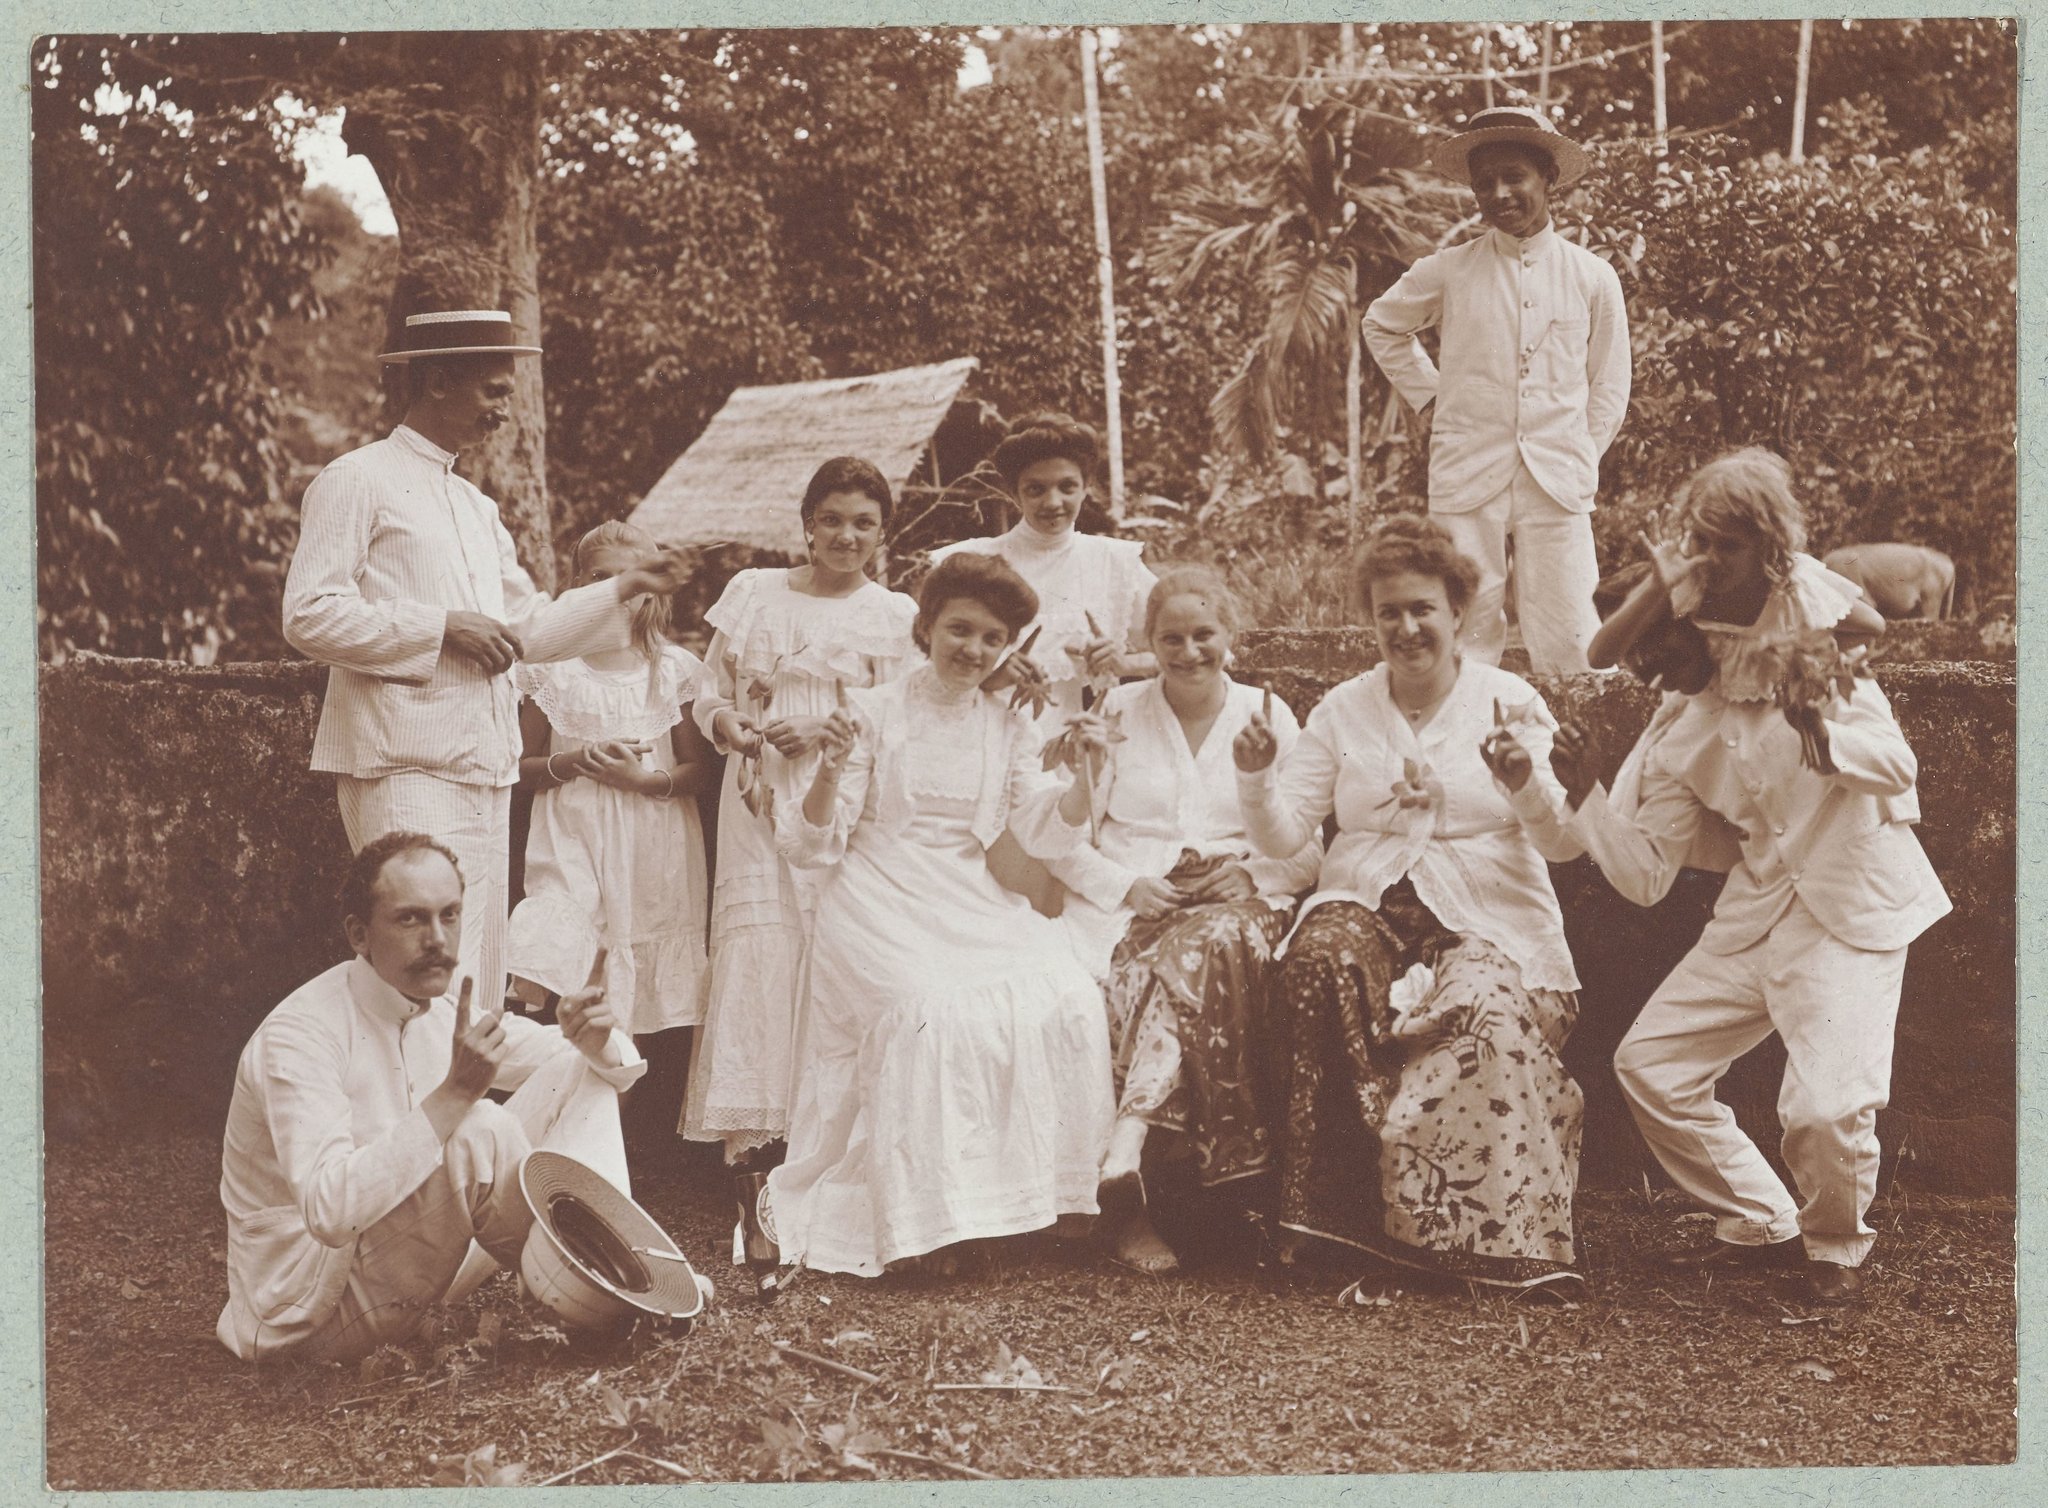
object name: photograph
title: Groepsportret van jolige mensen in Batuan, gekleed in het wit.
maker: frits freerks fontein fz.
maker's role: fotograaf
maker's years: 1882-1928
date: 1910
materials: cardboard, paper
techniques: gelatin silver print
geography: madura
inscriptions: caption: ‘Batoewan bij Soemenep 1910’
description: De mannen dragen witte tropenuniformen waarvan een man met tropenhelm, twee andere mannen dragen een strooien hoed, de vrouwen dragen witte jurken of batik rokken met witte hes. Foto uit album 'Photographieën".